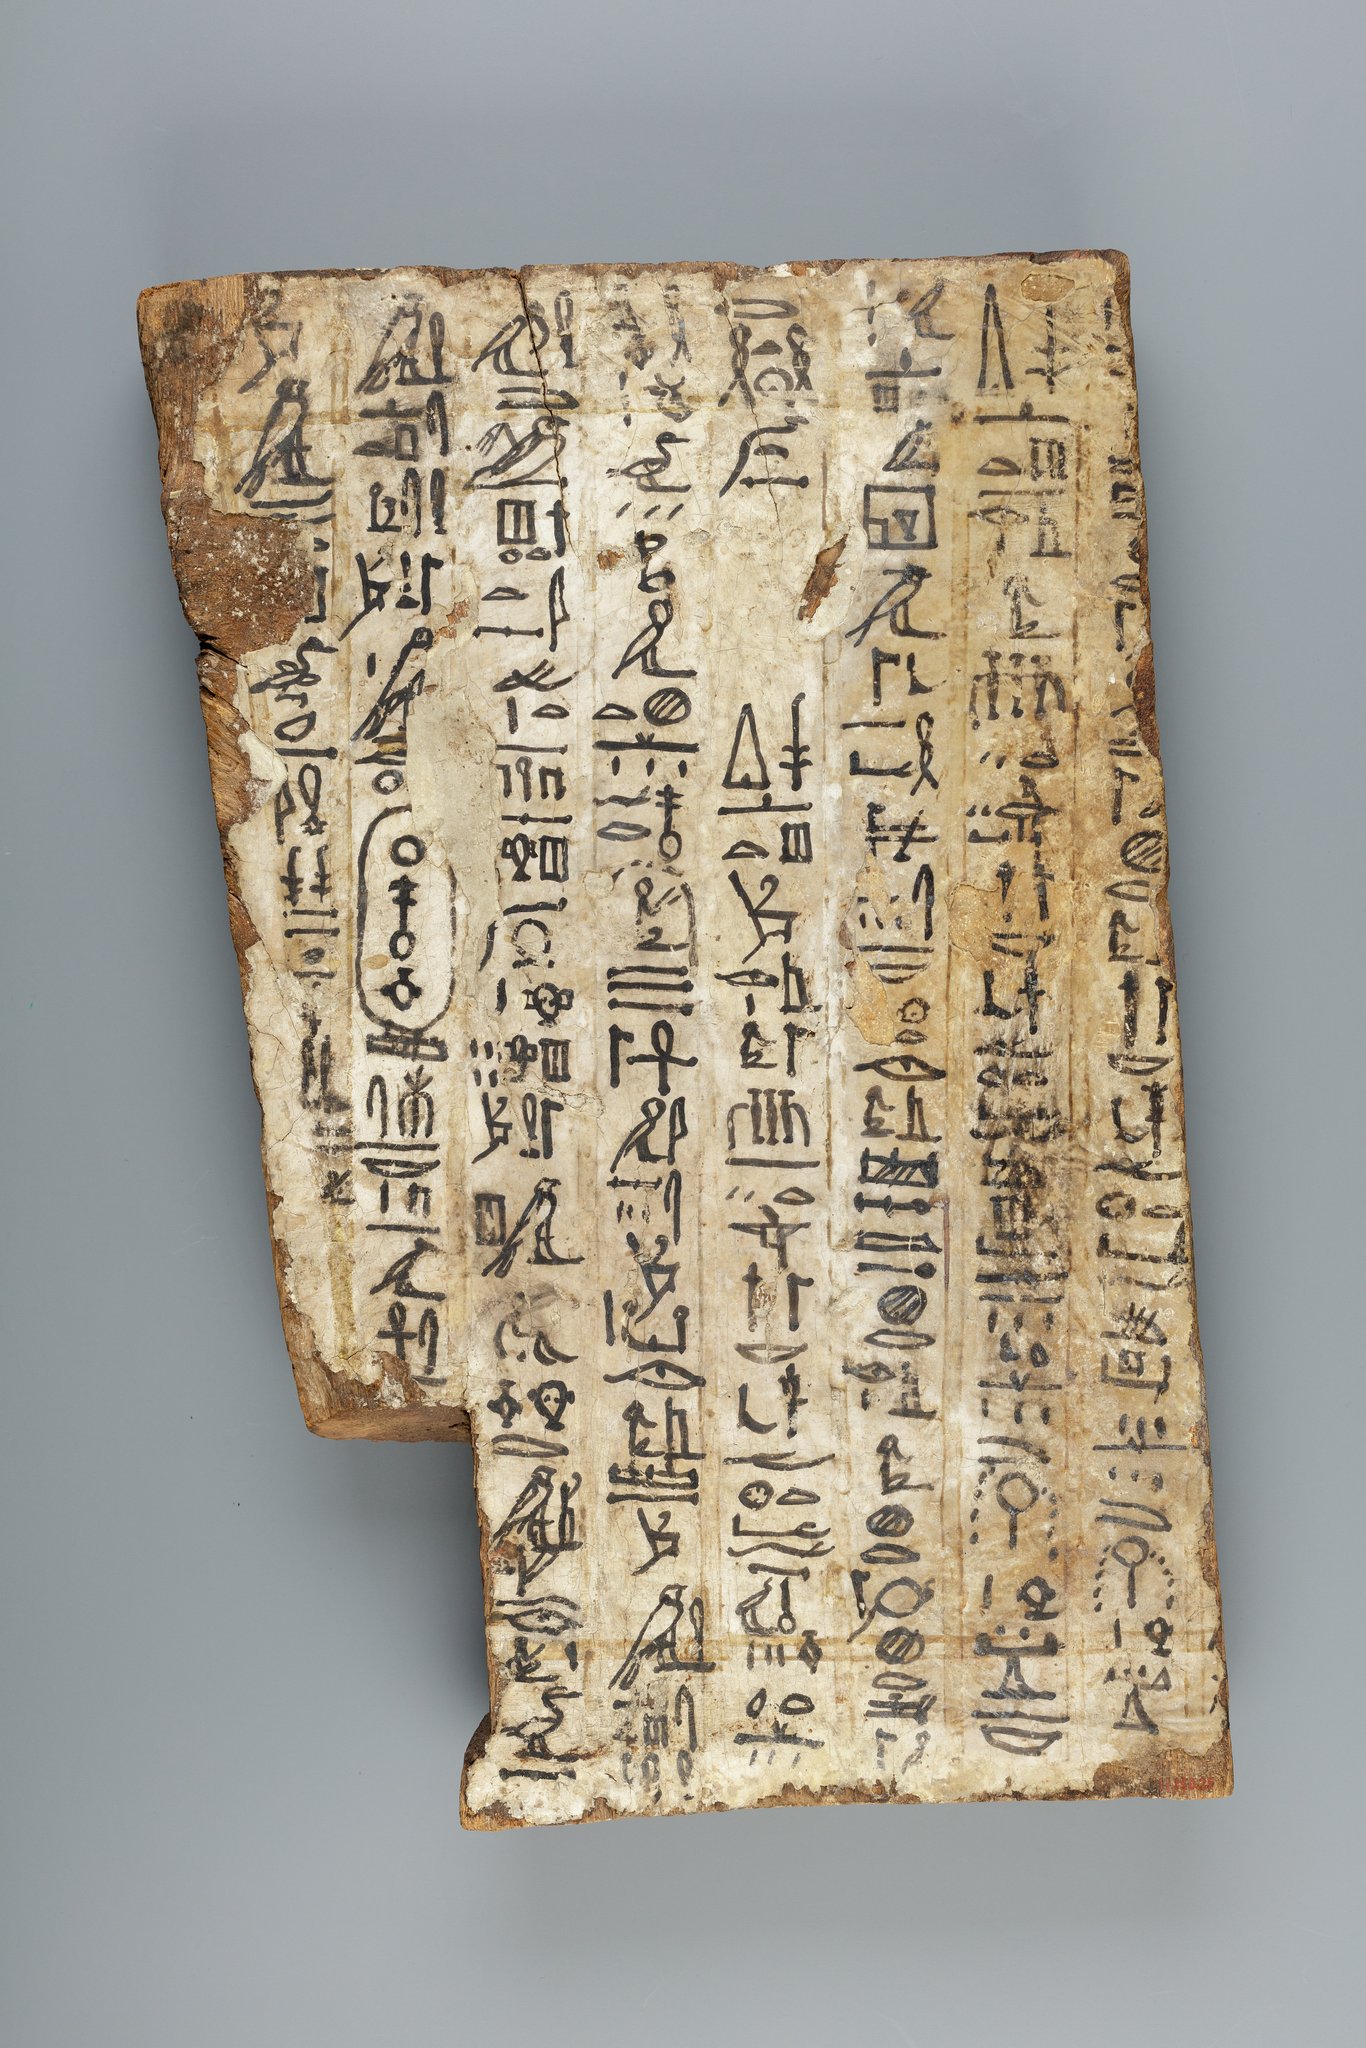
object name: writing board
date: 570-525 BCE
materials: ink, wood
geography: egypt